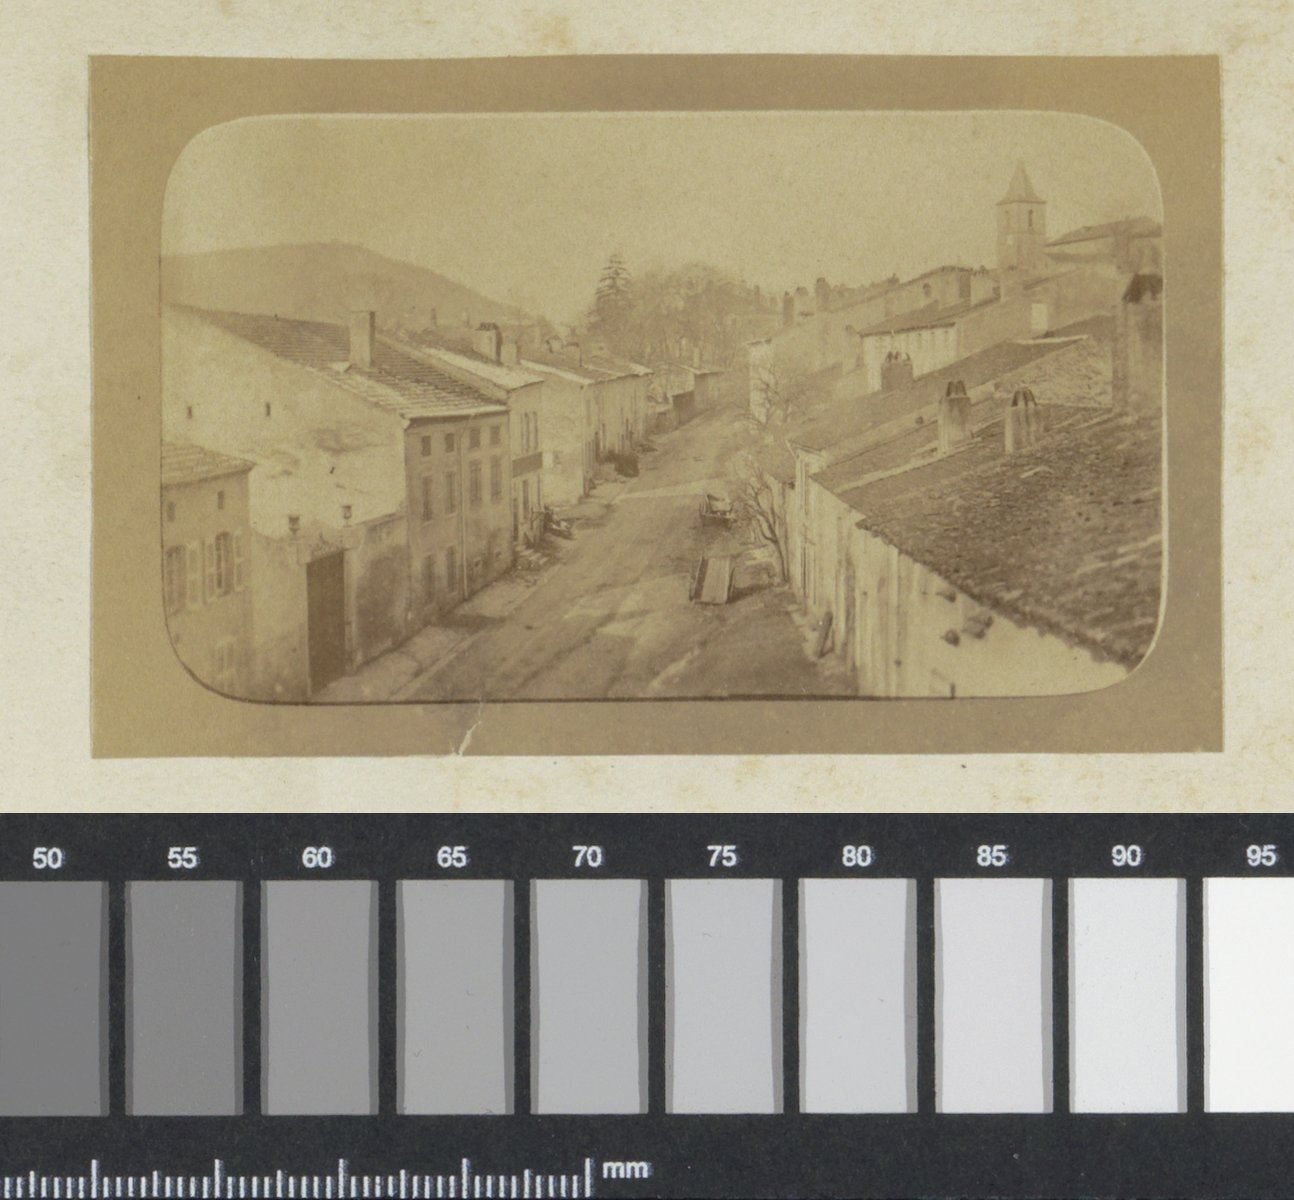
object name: photograph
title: Gezicht op een dorpsstraat, vermoedelijk in Arnaville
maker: Anonymous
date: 1883-1886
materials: photographic support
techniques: albumen print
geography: arnaville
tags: village street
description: Onderdeel van Album van een Franse amateurfotograaf met opnames van familie, militairen, industrie, landschappen en bezienswaardigheden in Frankrijk.